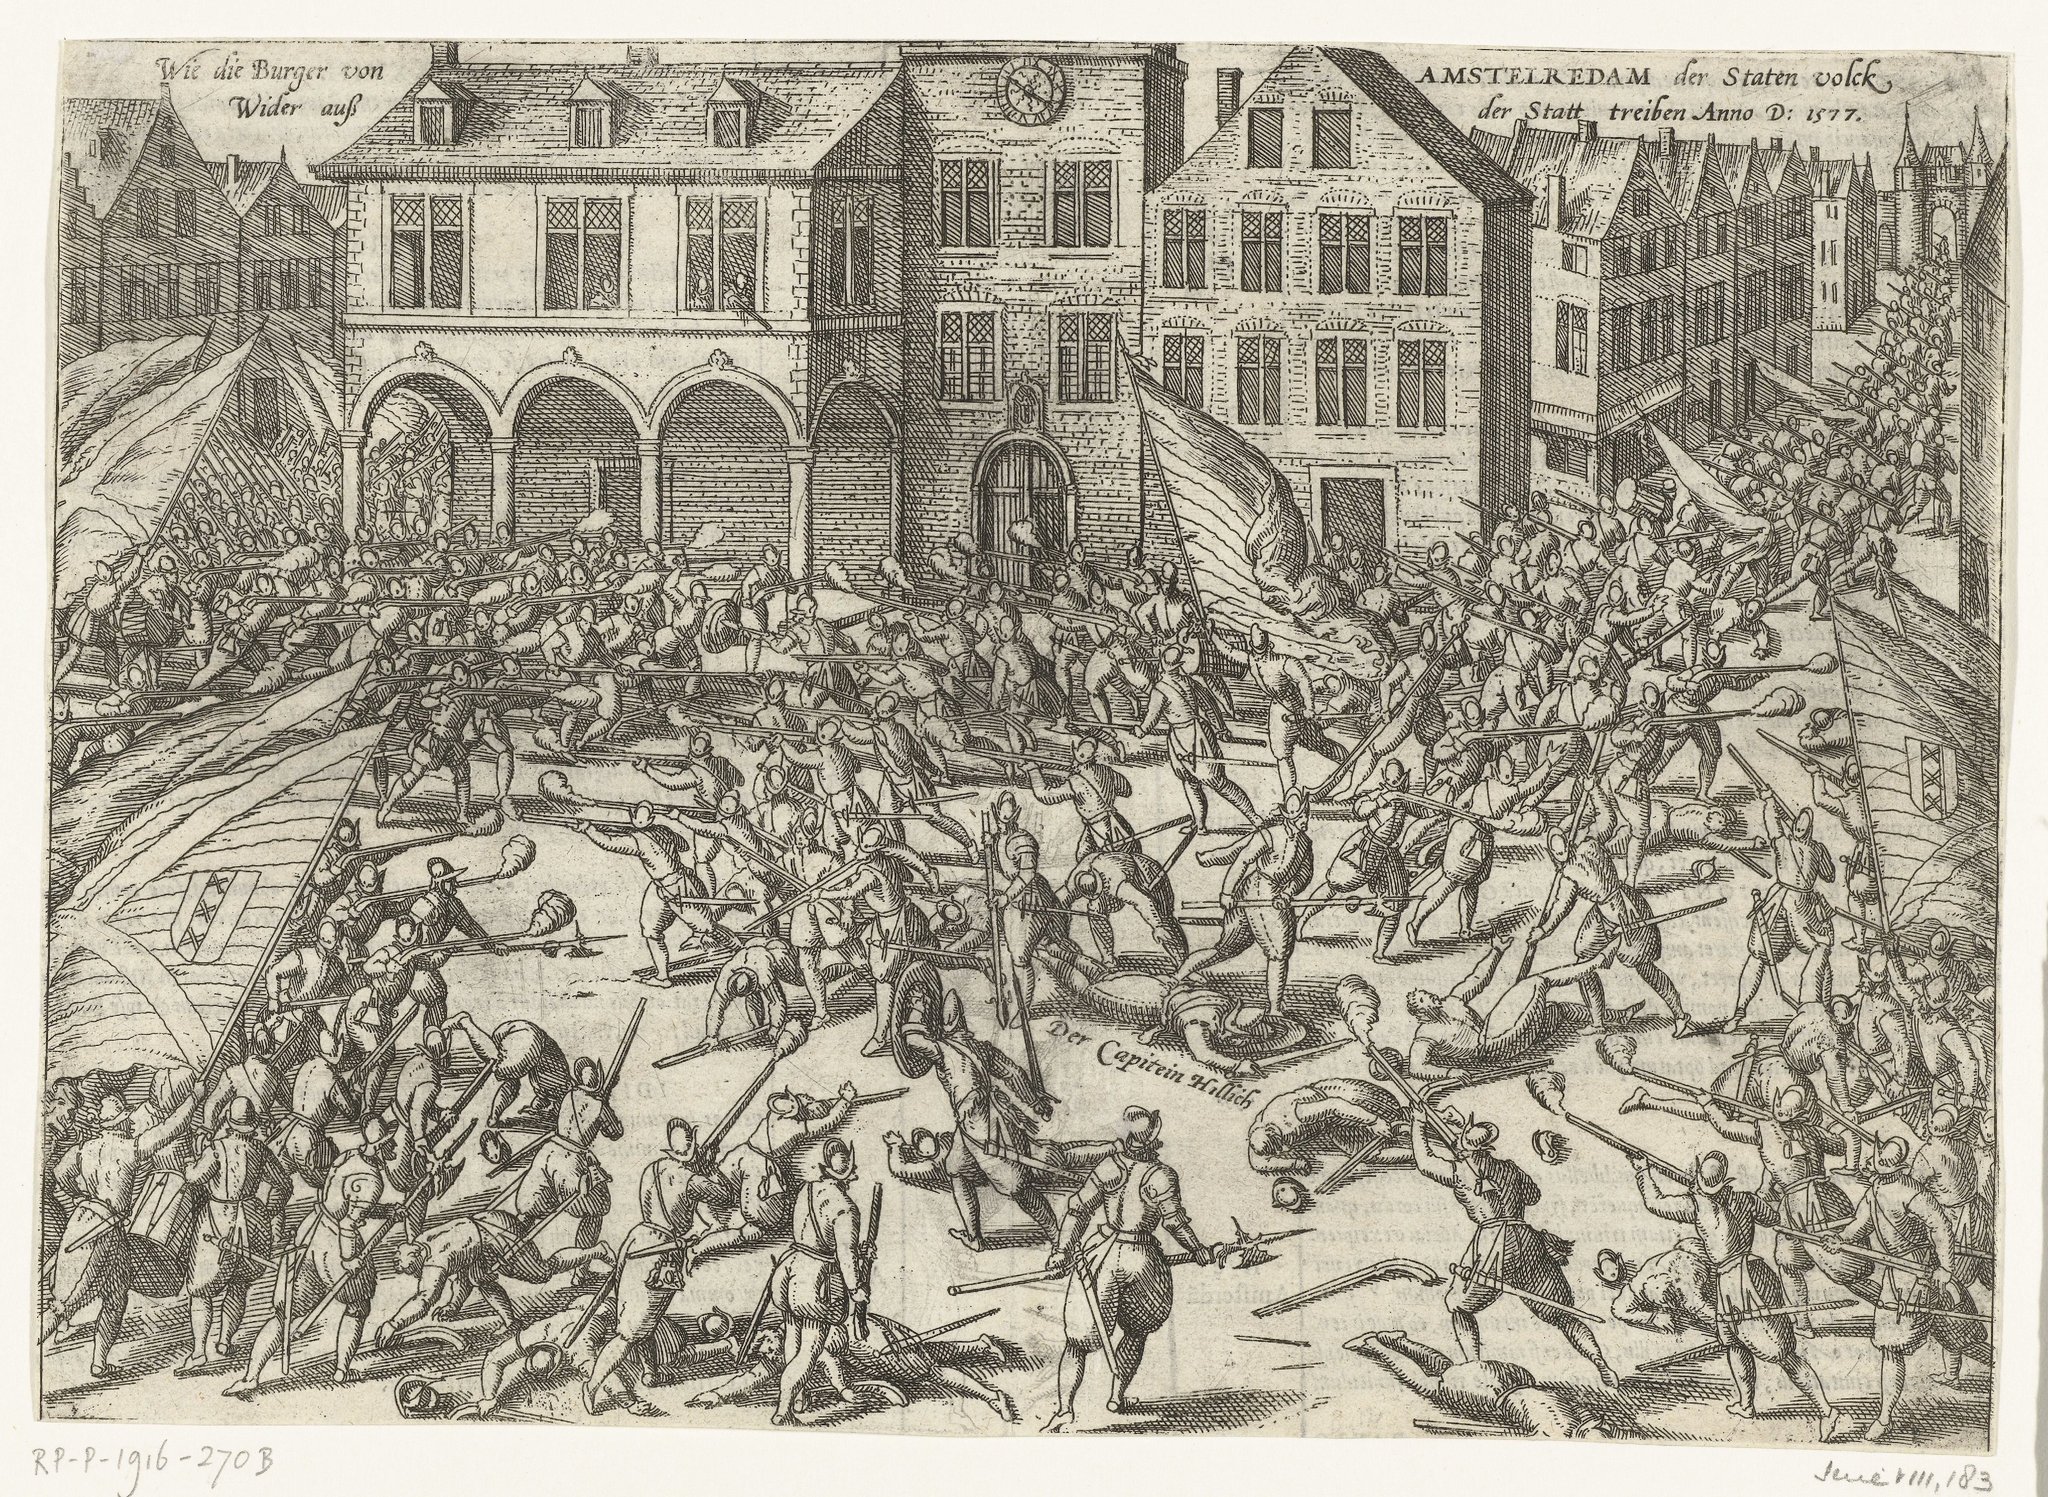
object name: print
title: Staatse troep verslagen op de Dam, 1577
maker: frans hogenberg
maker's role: print maker, publisher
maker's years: 1538-1590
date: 1577-1579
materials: paper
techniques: etching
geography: cologne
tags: haarlem, battle, fighting in general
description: De Staatse troepen onder bevel van Helling en Ruychaver worden bij felle gevechten op de Dam door de Amsterdammers verslagen. Helling zelf komt hierbij om het leven, 23 november 1577. Het onderschrift afgesneden waardoor het nummer ontbreekt. Op de verso Latijnse tekst.